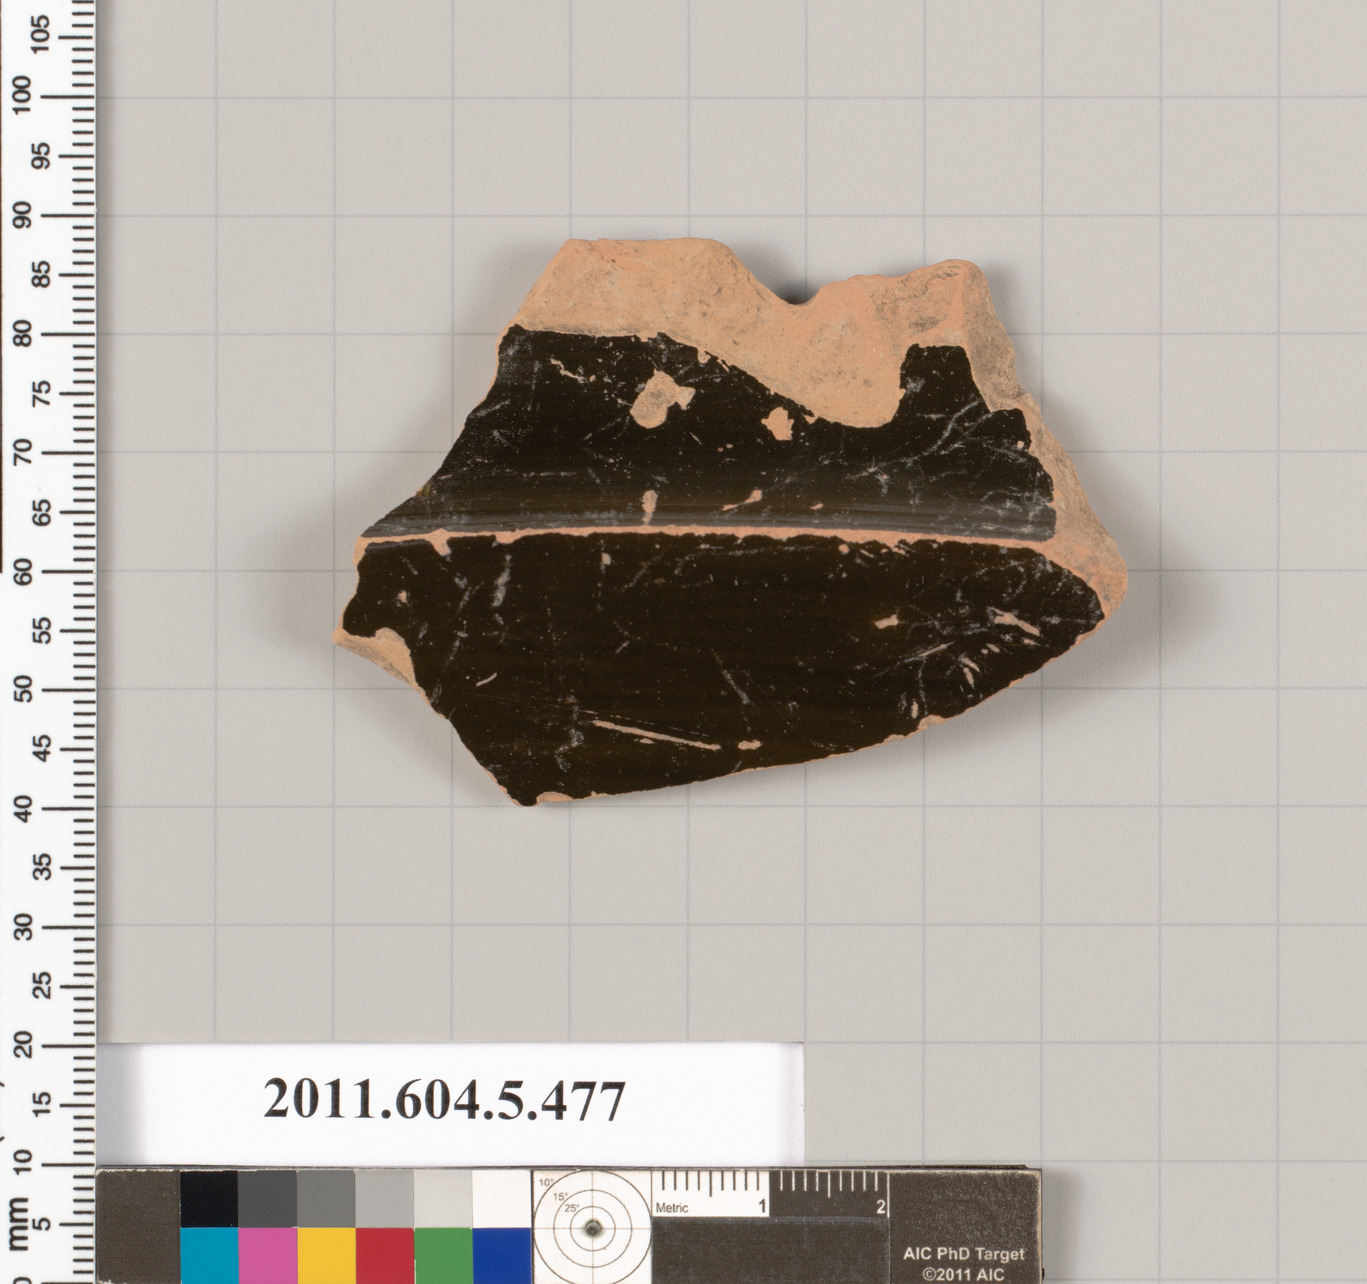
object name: kylix fragment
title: Terracotta fragment of a kylix (drinking cup)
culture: greek, attic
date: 600-401 BCE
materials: terracotta